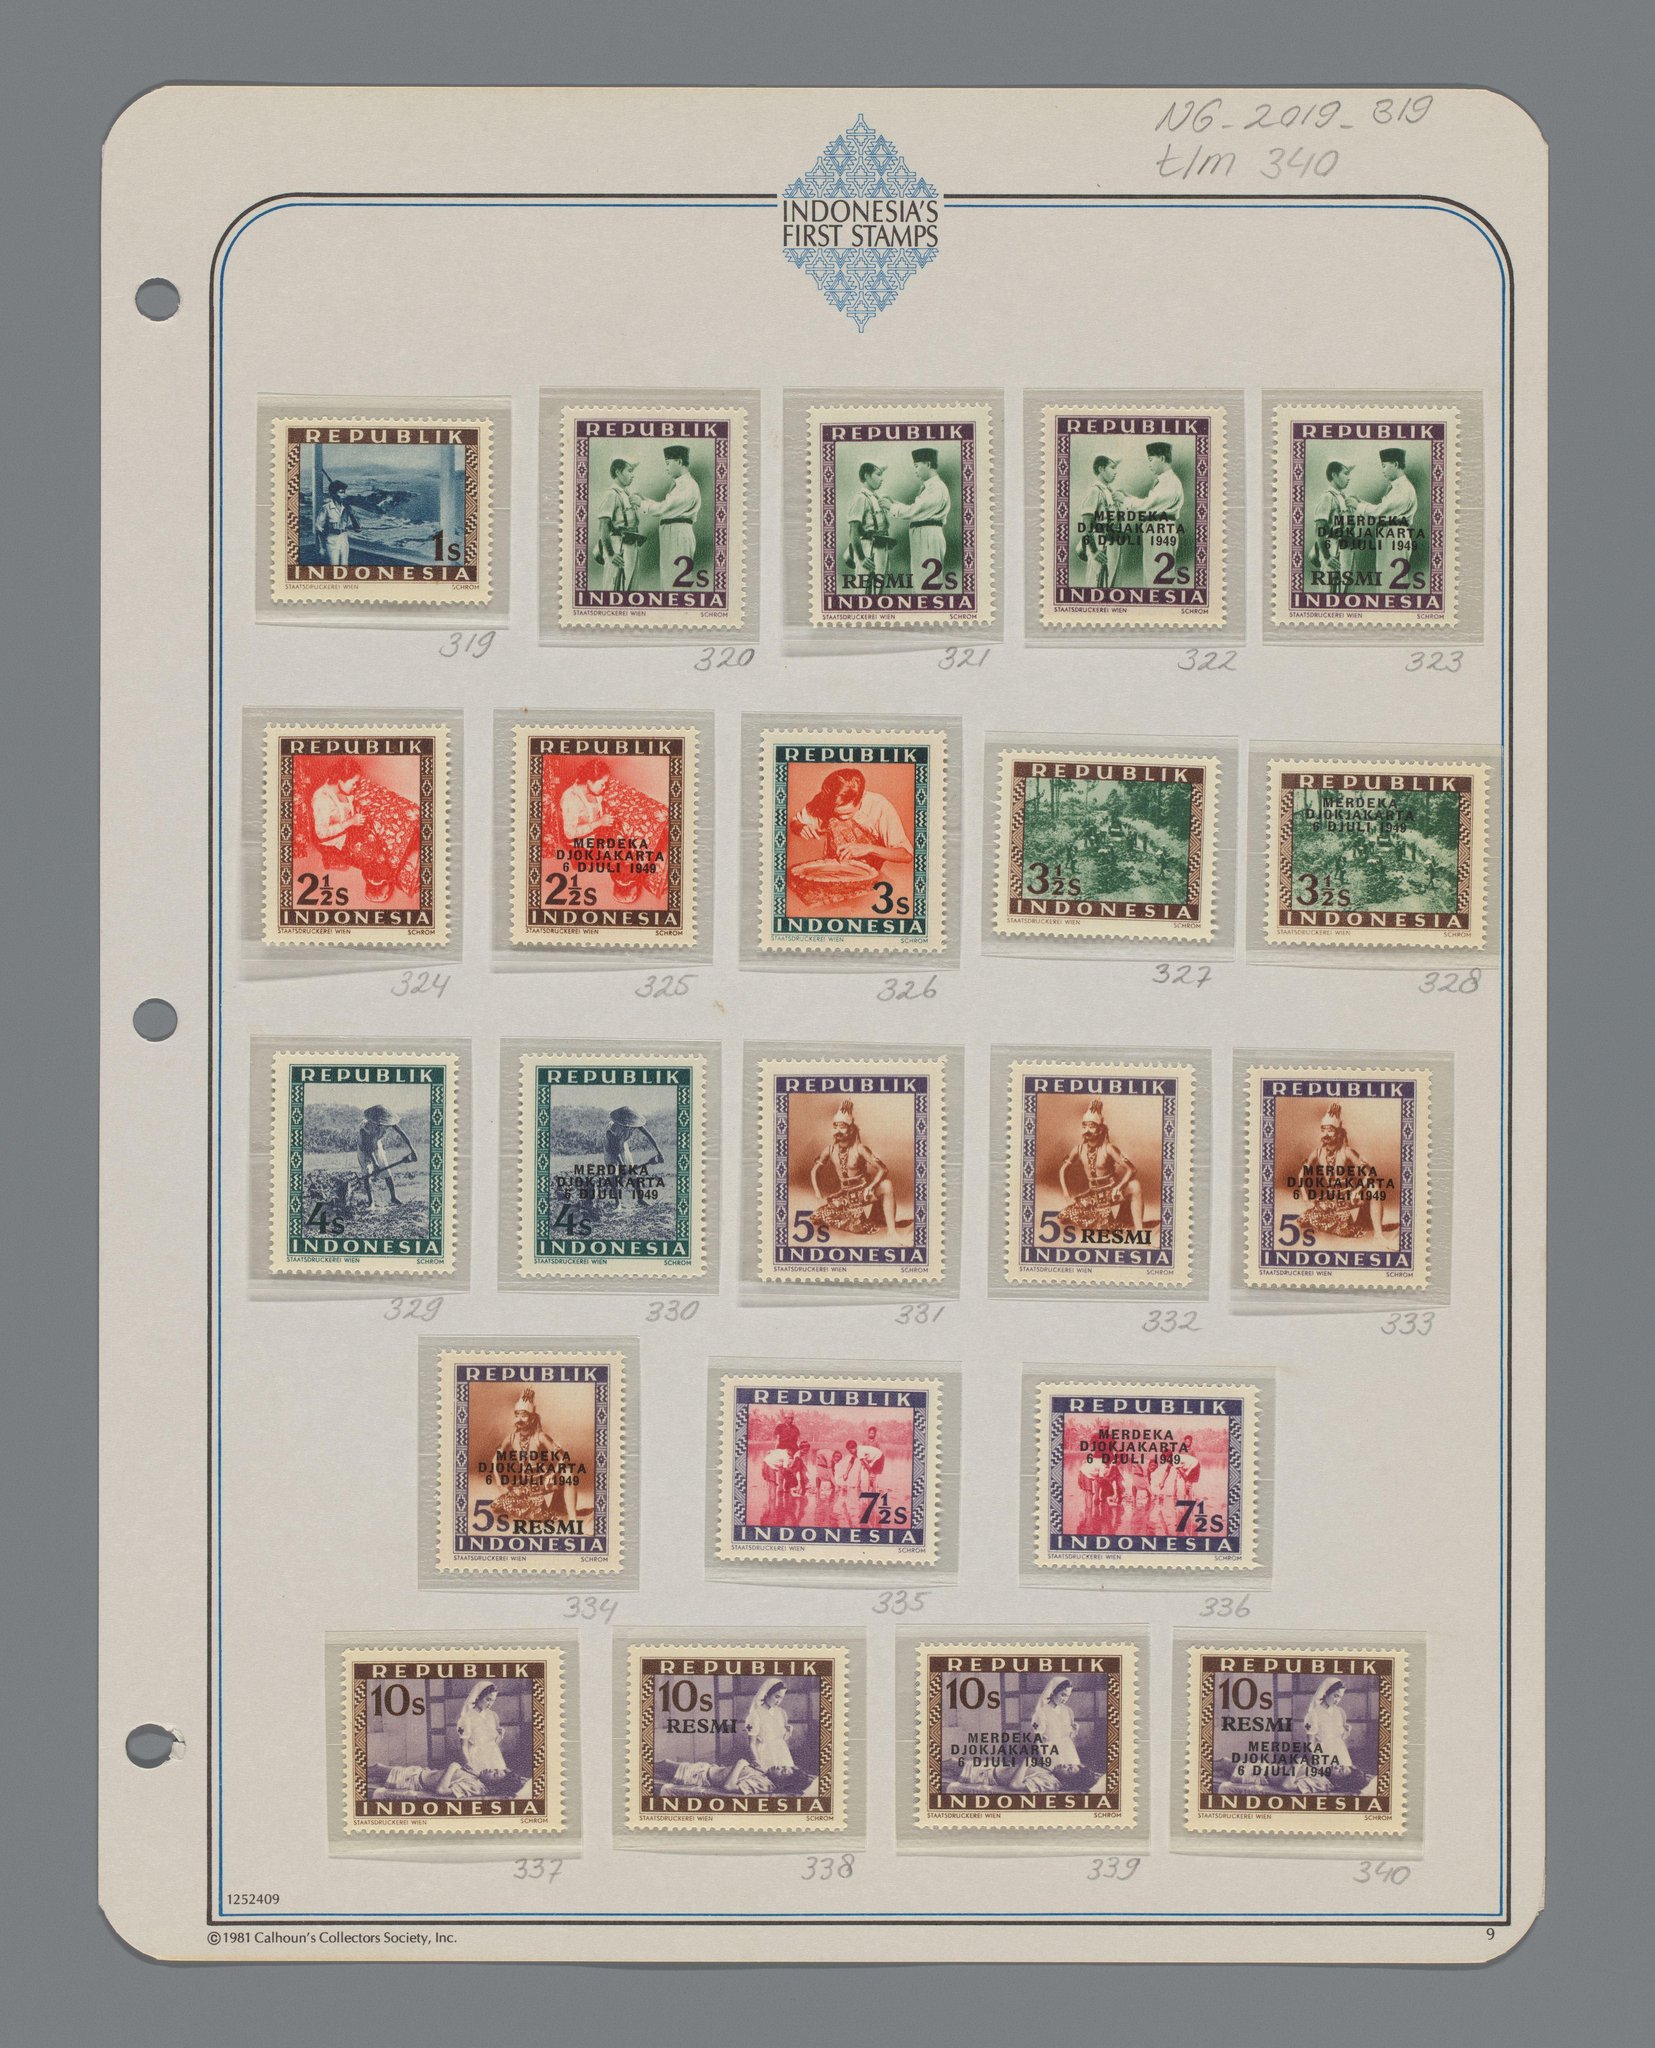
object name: postage stamp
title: Postzegel Republik Indonesia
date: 1949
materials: paper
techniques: photoaquatint, engraving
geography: vienna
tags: indonesia